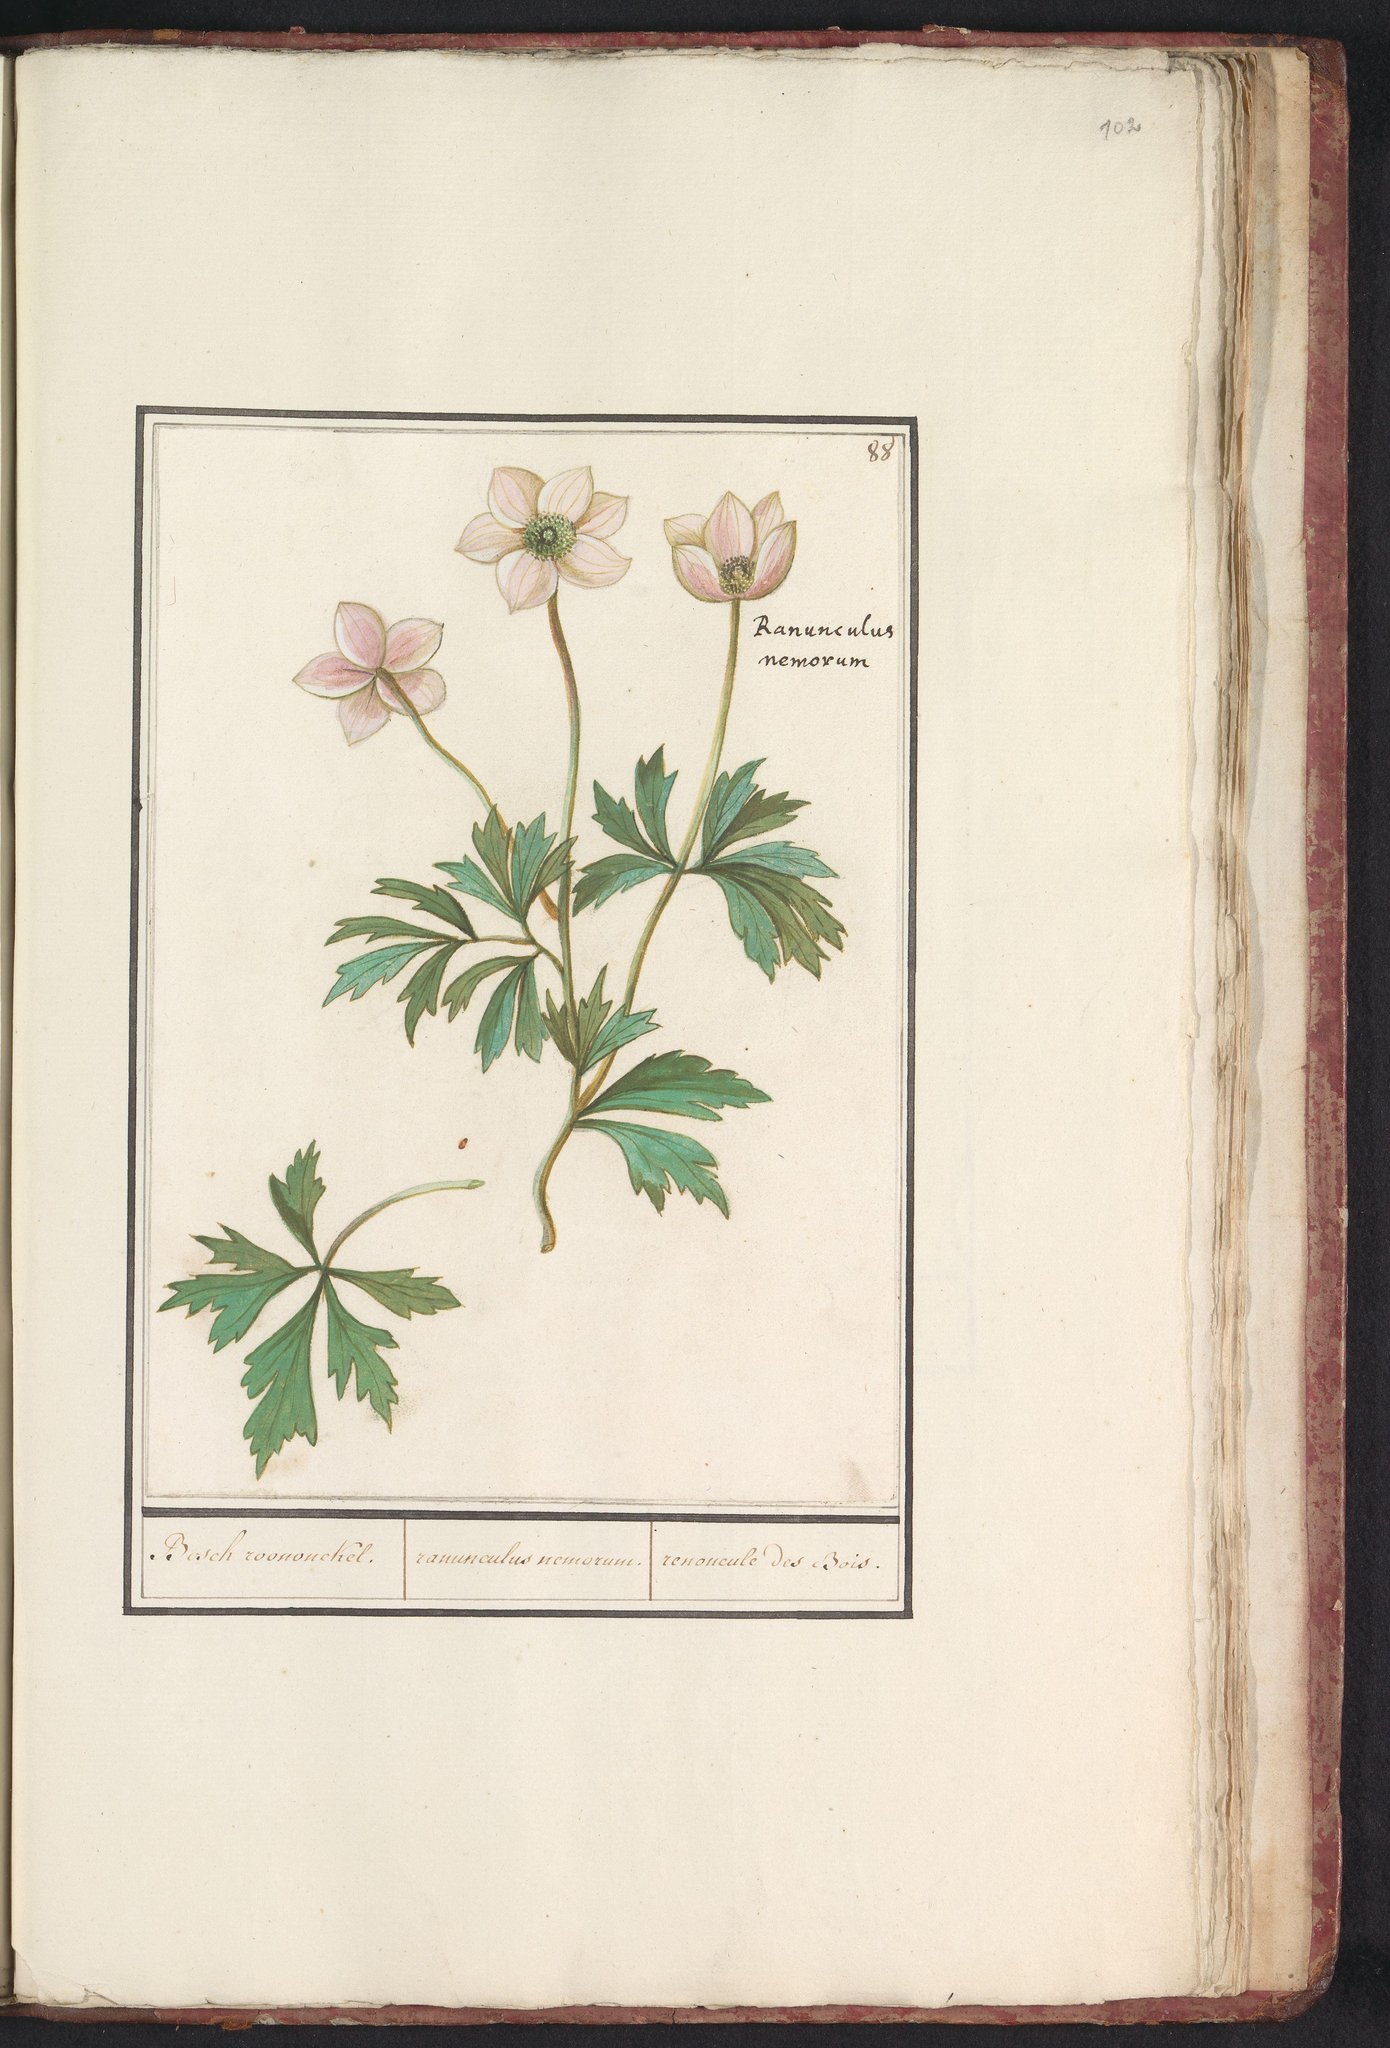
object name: drawing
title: Bosanemoon (Anemone nemorosa)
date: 1596-1610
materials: chalk, paint, ink, paper, watercolor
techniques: brush, pen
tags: flowers: wood anemone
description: Witte bosanemoon. Genummerd rechtsboven: 88. Met de Latijnse naam. Onderdeel van het eerste album met tekeningen van bloemen en planten. Achtste van twaalf albums met tekeningen van dieren, vogels en planten bekend rond 1600, gemaakt in opdracht van keizer Rudolf II. Met toelichting in Nederlands, Latijn en Frans.